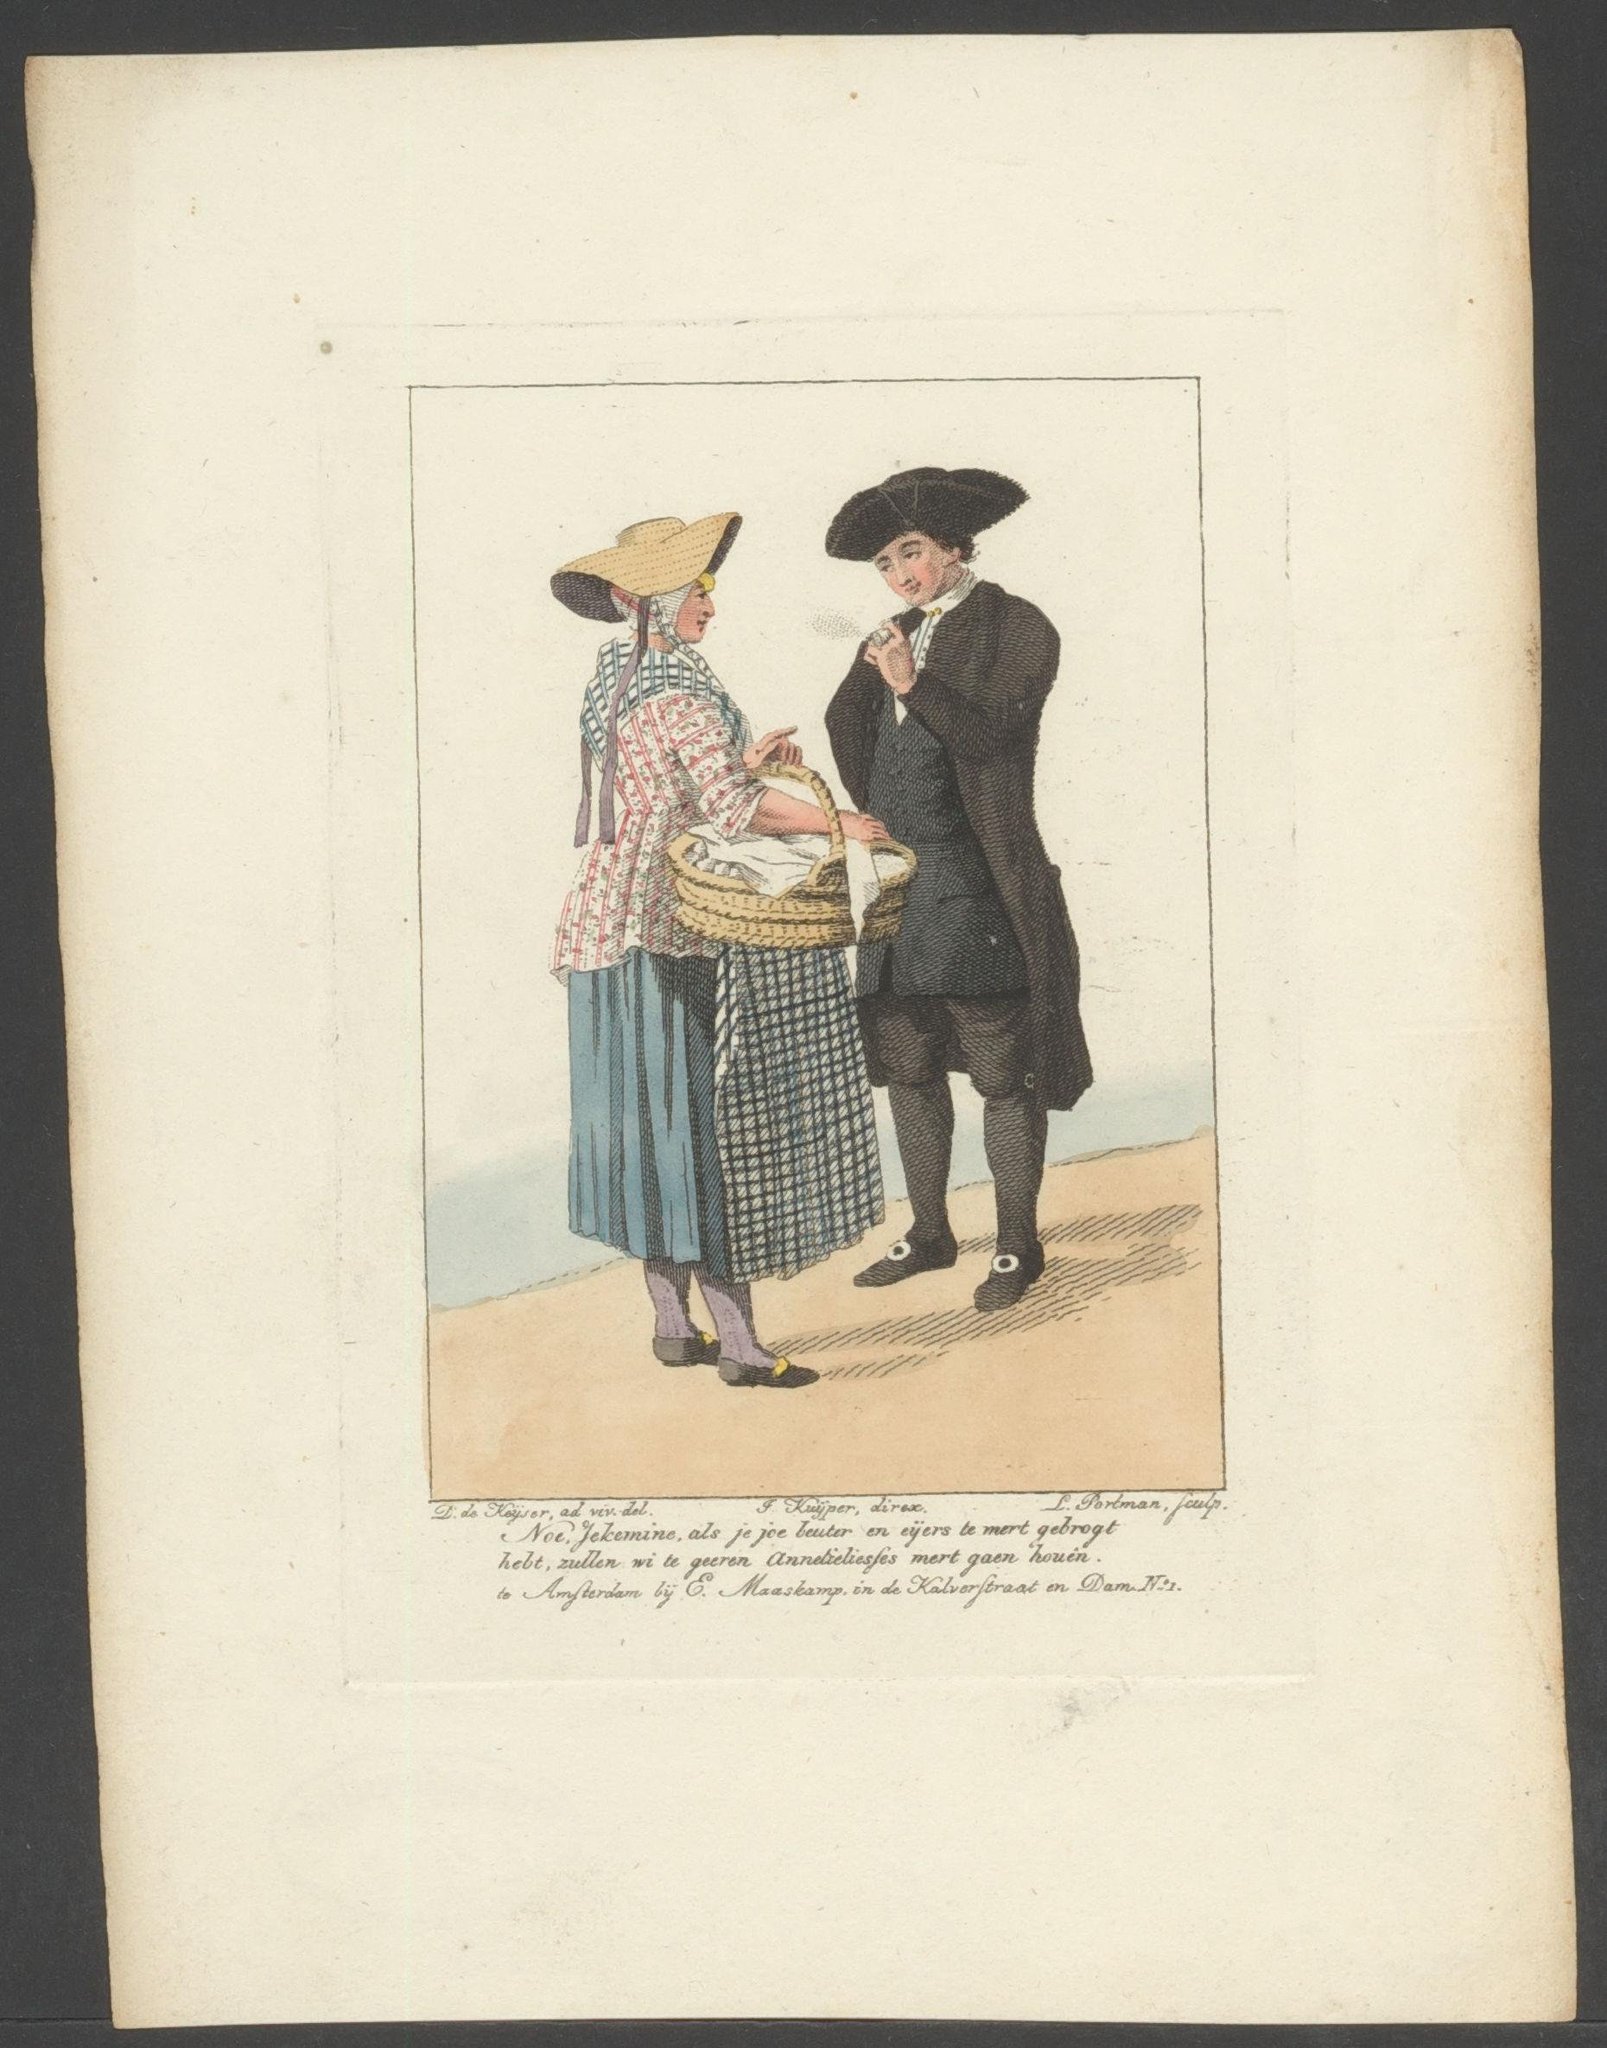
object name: print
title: Heer en boerin uit Zuid-Beveland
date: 1813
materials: paper, watercolor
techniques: etching, hand coloring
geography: netherlands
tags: farmers - aa - female farmer, farmer's wife, clothes, costume (+ women's clothes), clothes, costume (+ men's clothes), folk costume, regional costume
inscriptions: collector's mark: Lugt 1641, collector's mark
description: Heer en boerin uit Zuid-Beveland. De jonge vrouw met een mand met boter en eieren aan de arm, in gesprek met een pijprokende man in het zwart. Bij de prent zit ook een blad met de Franse titel. Onderdeel van de verkleinde kopieën uit 1812 naar de platen van Nederlandse klederdrachten uit de jaren 1803-1807. Onderwerpsrubrieken binnen de Atlas Zeden en Gewoonten: De Kleeding, Volkskleederdracht.